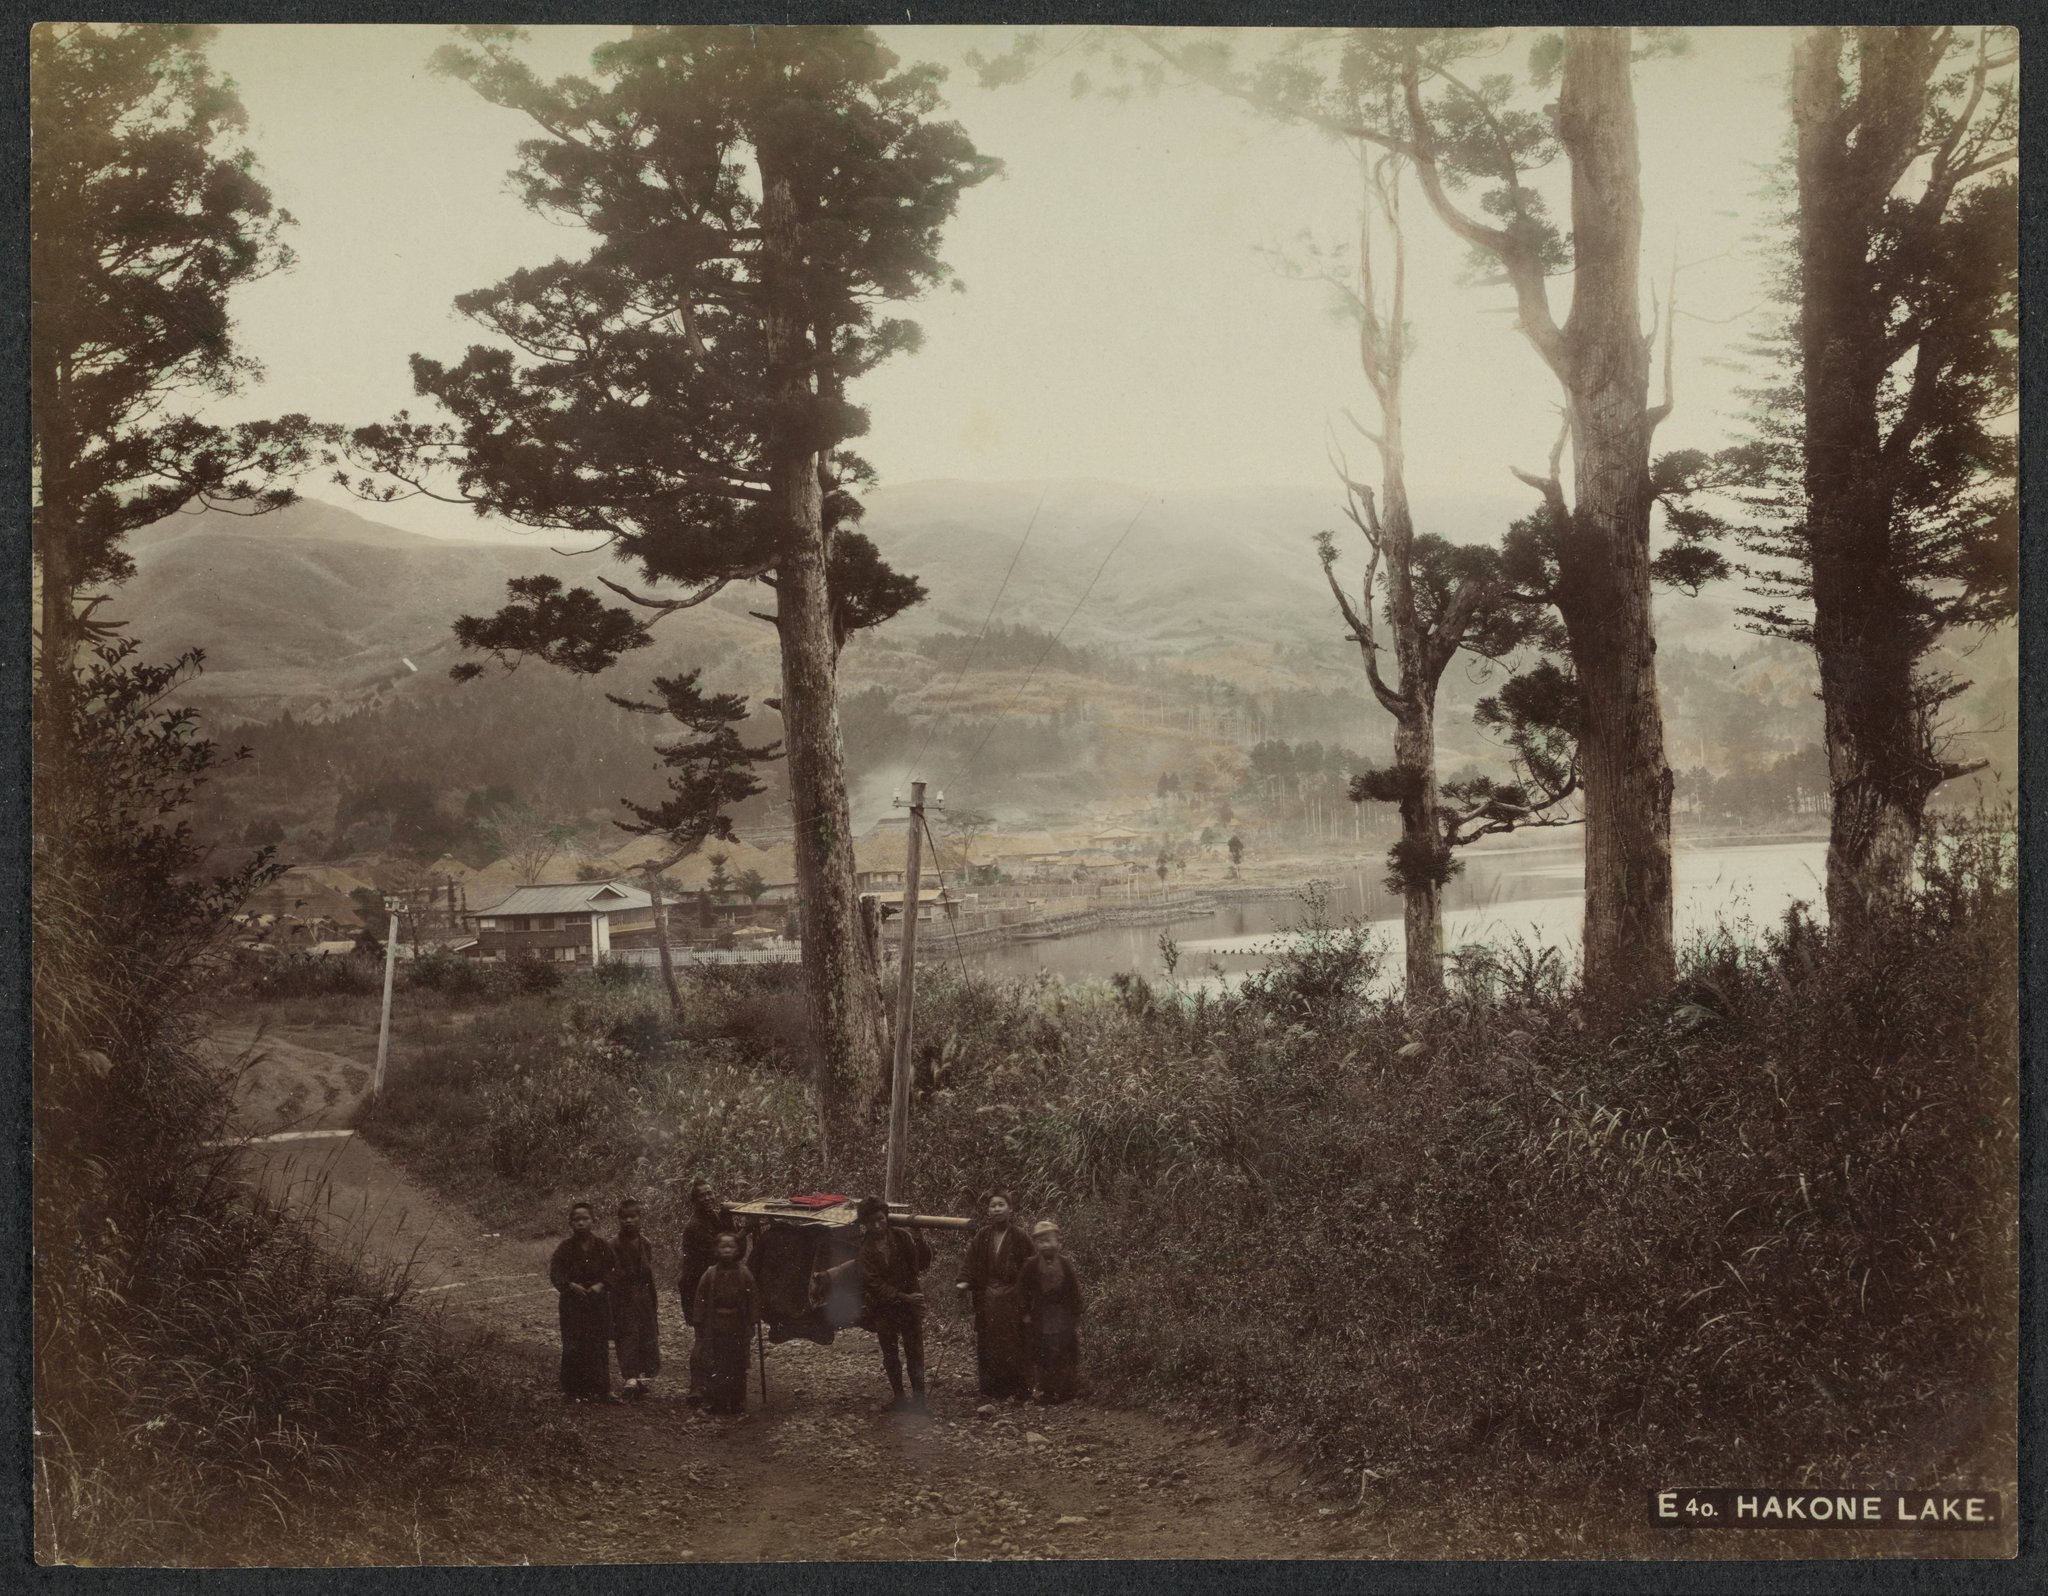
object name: photograph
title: Hakone Lake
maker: Anonymous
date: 1890-1894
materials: cardboard, paper, photographic support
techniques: albumen print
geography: hakone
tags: (carrying a person in a) sedan-chair, lake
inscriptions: negative number: ‘E40’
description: Onderdeel van Album met 69 foto's van een reis door Japan.